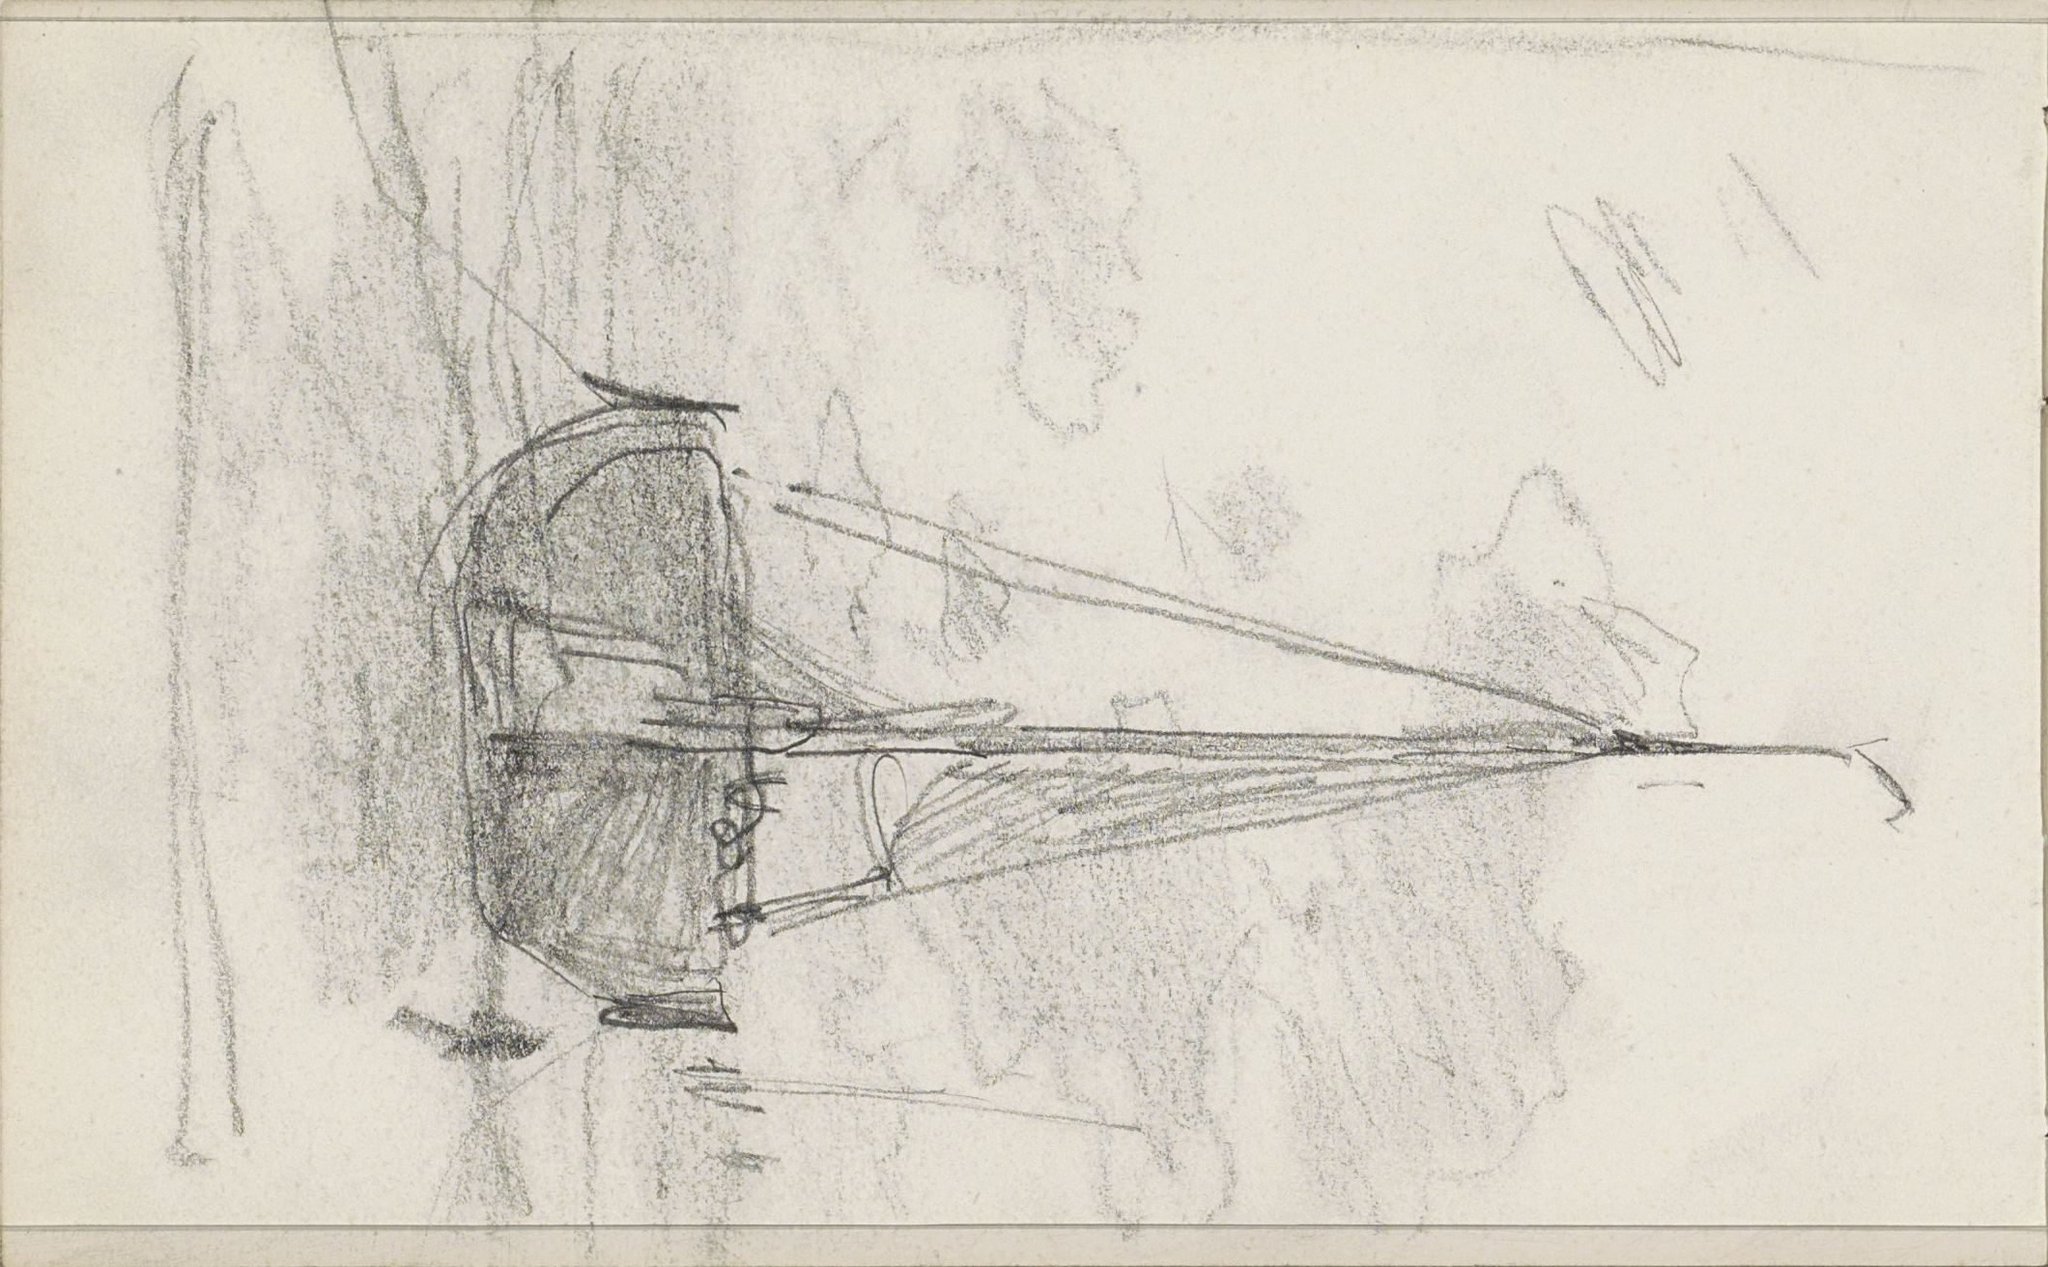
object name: sketchbook leaf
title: Zeilschip op het strand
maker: anton mauve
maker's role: draughtsman, painter, print maker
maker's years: 1838-1888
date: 1848-1888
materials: paper, pencil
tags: sailing-ship, sailing-boat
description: Mogelijk een bomschuit. Blad 13 verso uit een schetsboek met 43 bladen.